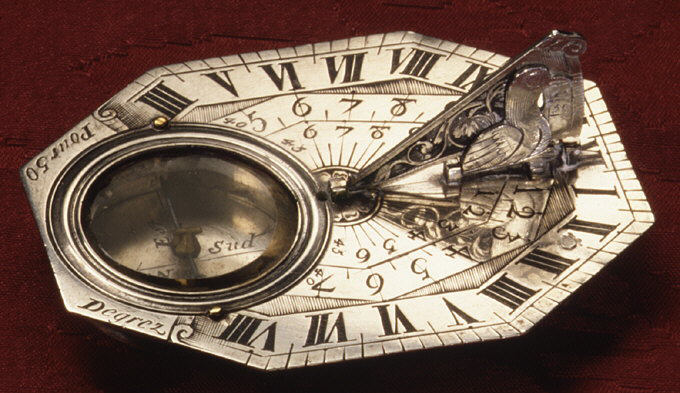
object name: sundial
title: Portable horizontal sundial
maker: jacques lucas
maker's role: maker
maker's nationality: french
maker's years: 1660-1721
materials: silver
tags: birds